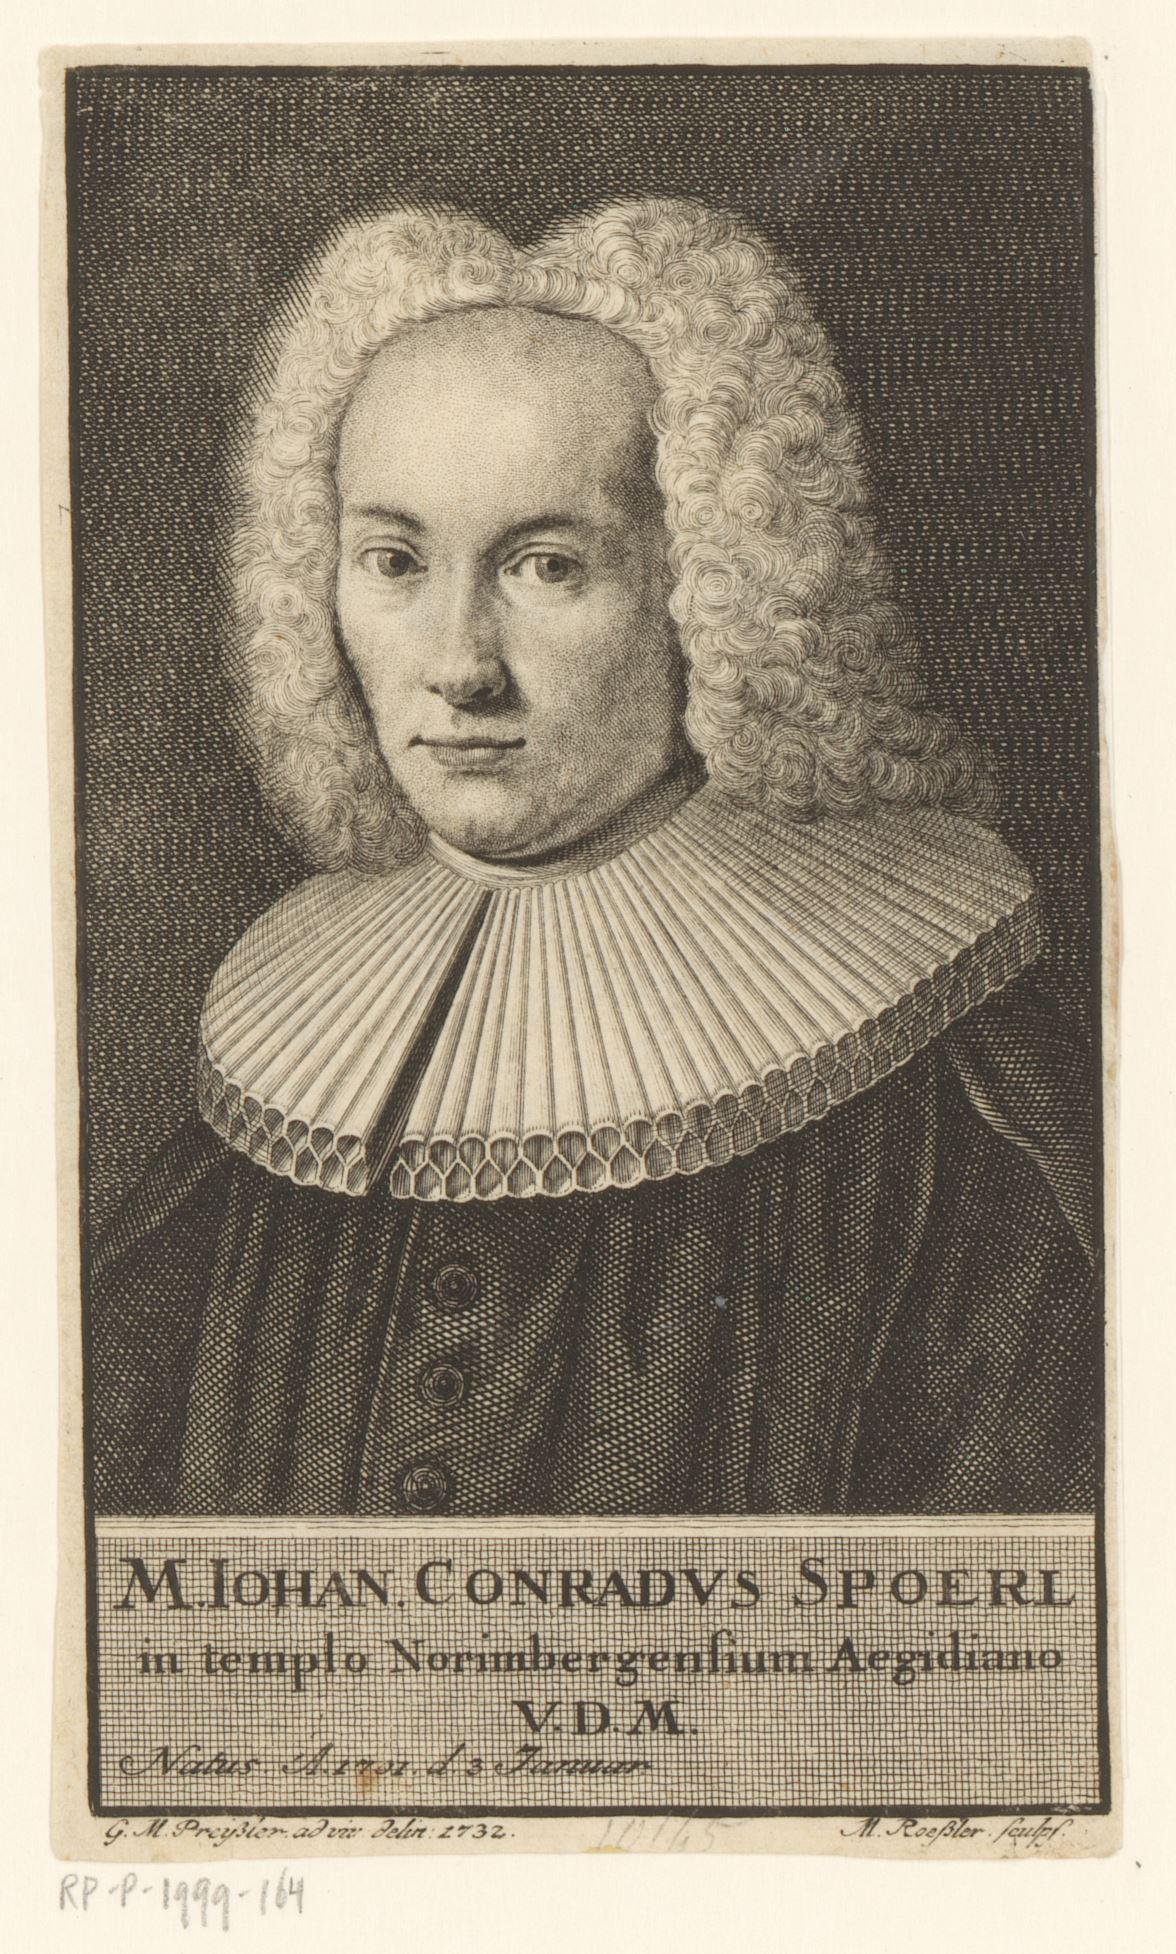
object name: print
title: Portret van Johann Konrad Spoerl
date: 1732-1777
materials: paper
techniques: engraving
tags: historical persons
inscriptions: collector's mark: Lugt 2228